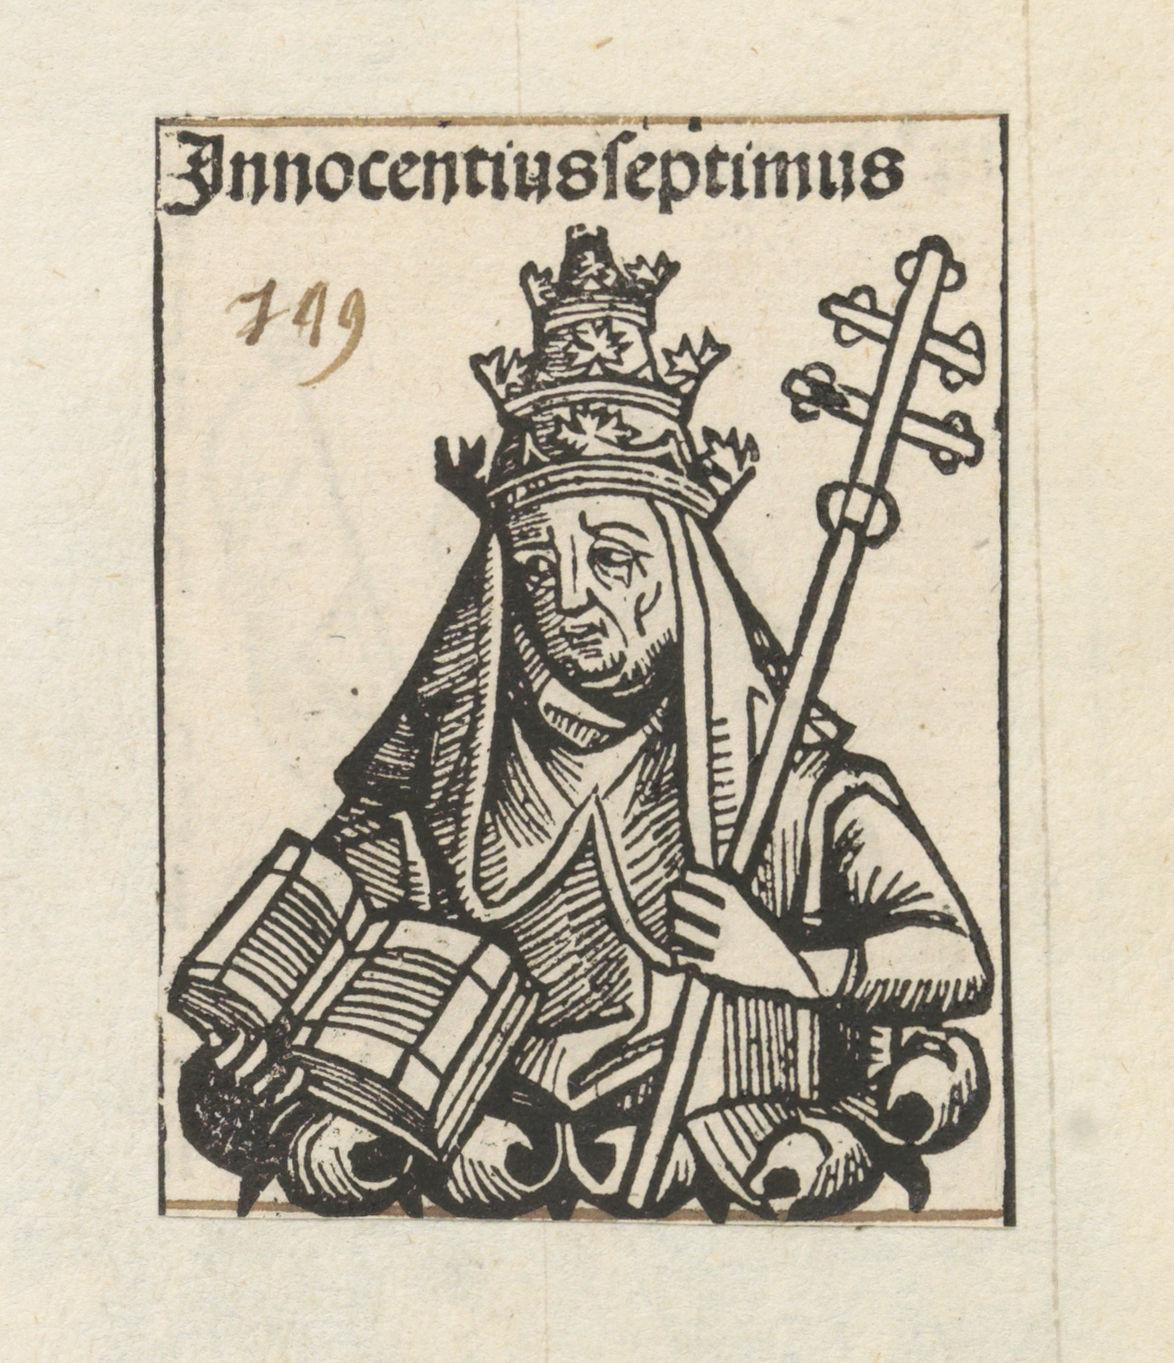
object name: album leaf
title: Liber Chronicarum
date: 1493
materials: paper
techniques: letterpress printing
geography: nuremberg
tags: rome, pope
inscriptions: inscription: ‘149’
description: Een bloemkelk met een paus. Hij draagt een tiara en heeft een opengeslagen boek en een staf met dubbel kruis in zijn handen. De voorstelling is onderdeel van de opeenvolging pausen in de Liber Chronicarum. De tekst identificeert de man als Innocentius VII. De prent maakt deel uit van een album.